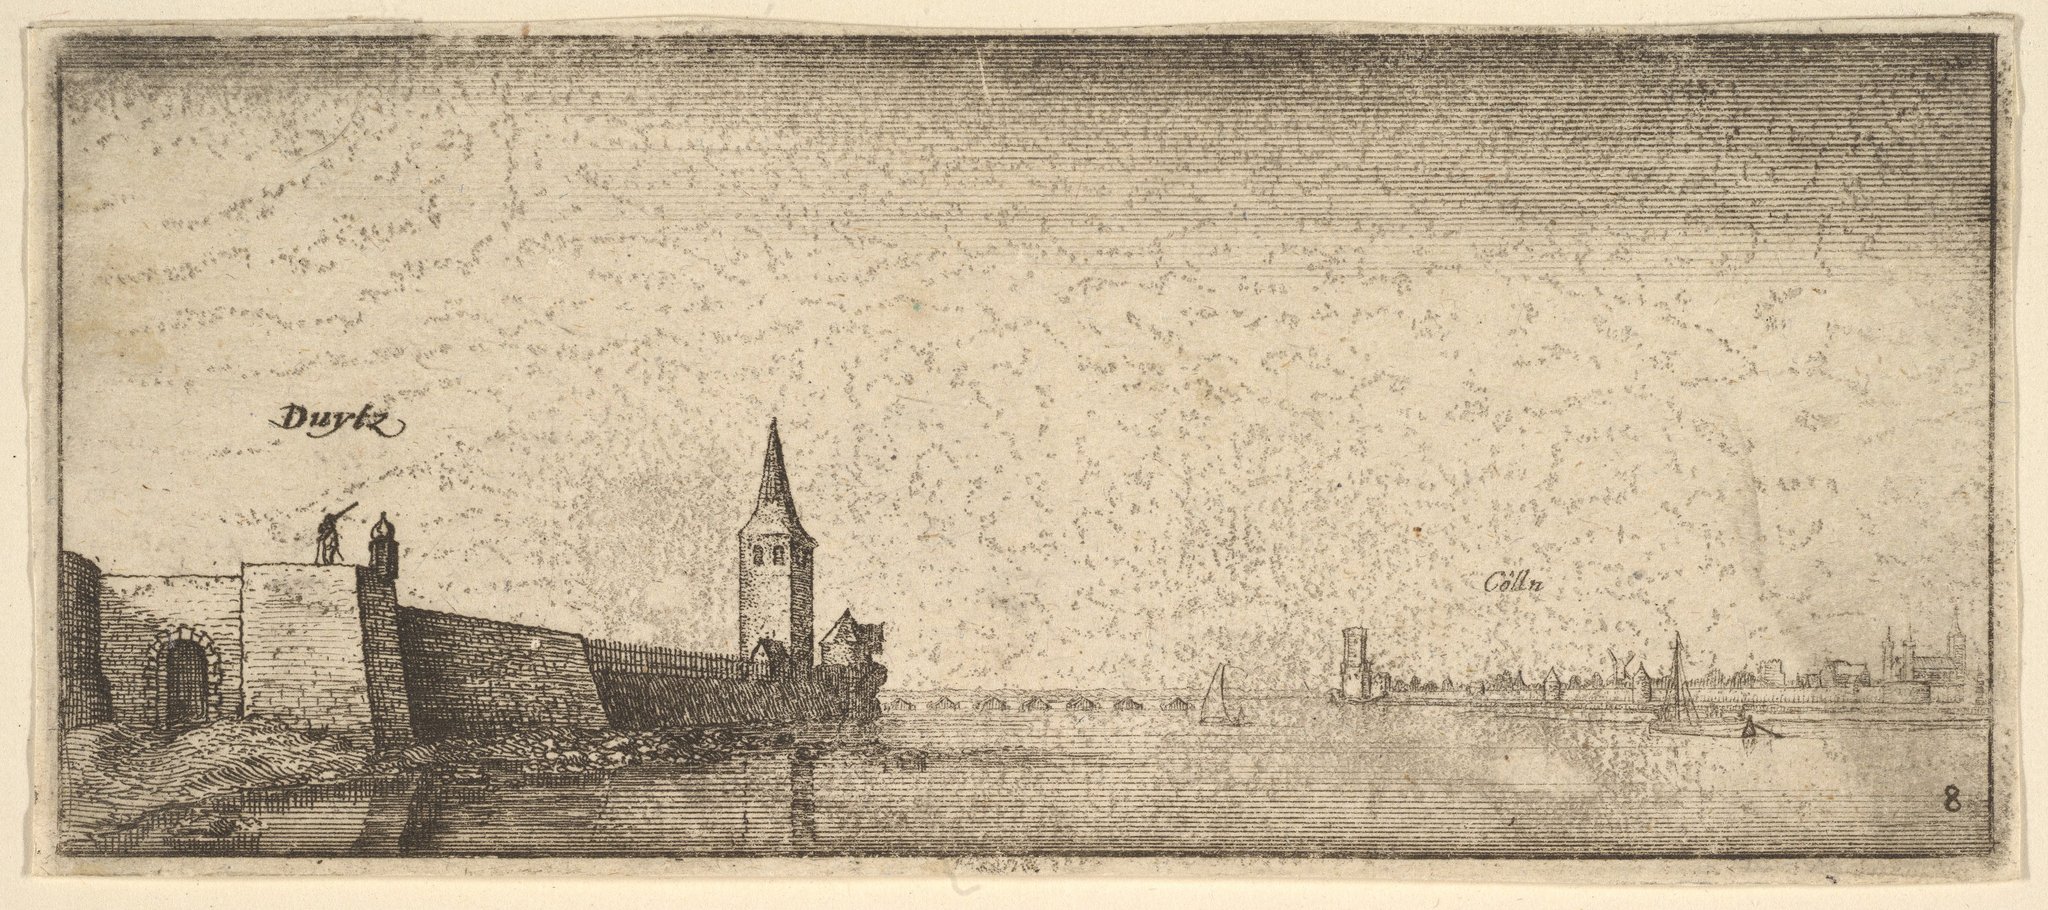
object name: print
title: Deutz and Cologne, from "German Views"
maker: wenceslaus hollar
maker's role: artist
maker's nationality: bohemian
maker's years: 1607-1677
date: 1652-1677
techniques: etching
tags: buildings,boats